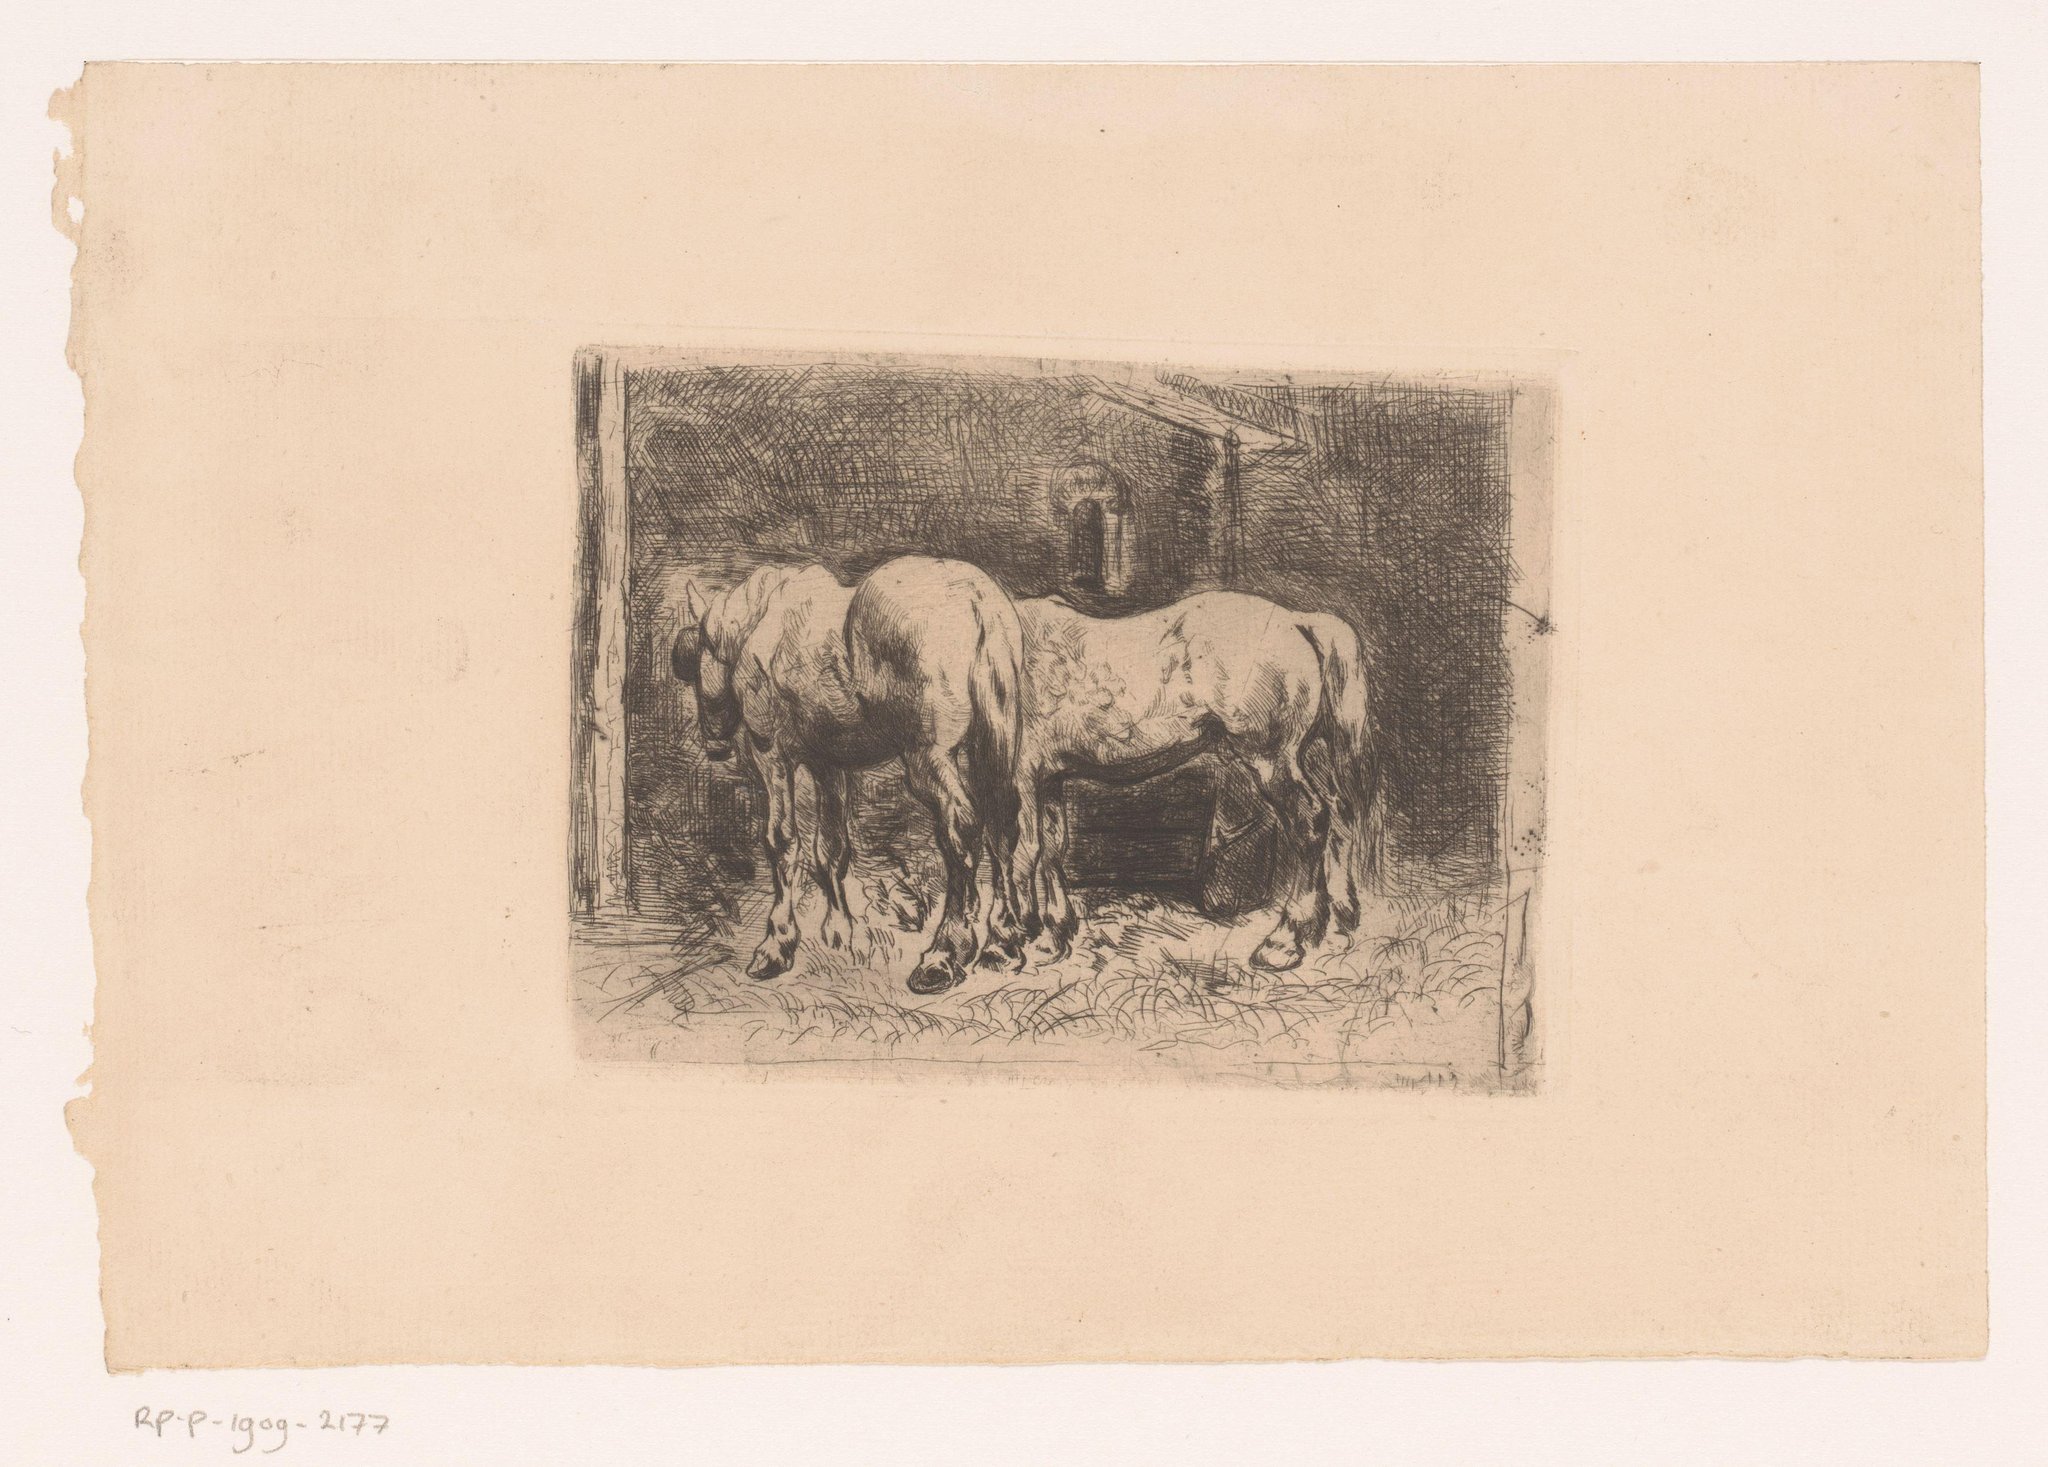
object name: print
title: Twee paarden op stal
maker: vicomte arthur-jean le bailly dinghuem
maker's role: print maker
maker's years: 1839-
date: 1850-1899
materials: paper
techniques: etching, intaglio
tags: barn, horse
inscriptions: collector's mark: Lugt 2228